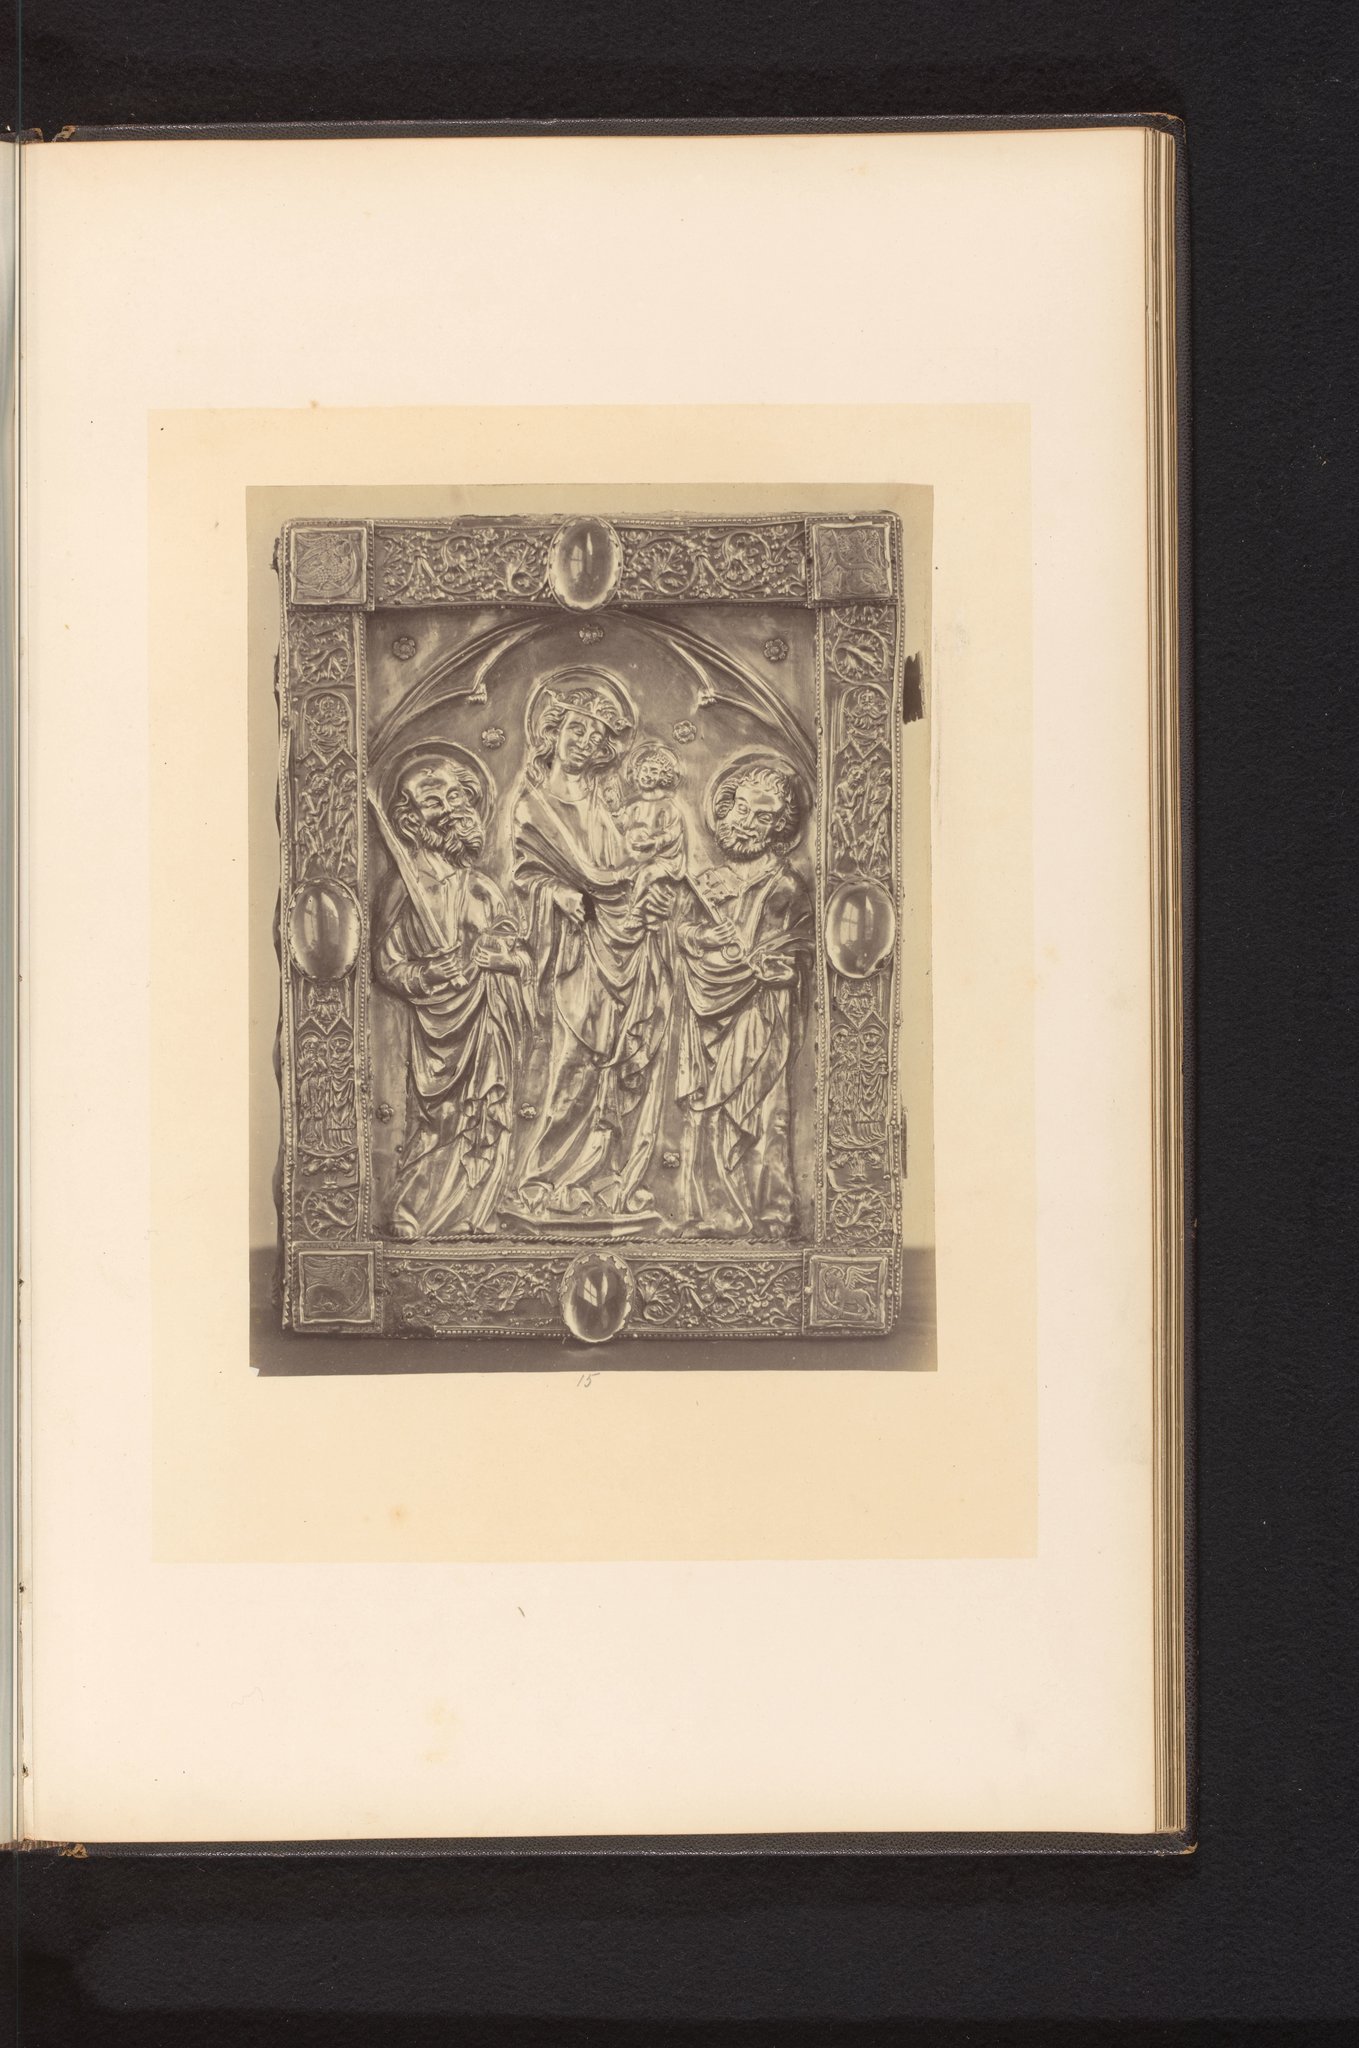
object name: photograph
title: Boekband met Maria en kind en Pieter en Paulus uit de Onze-Lieve-Vrouwebasiliek in Tongeren, opgesteld op een tentoonstelling over religieuze objecten uit de middeleeuwen en renaissance in 1864 in Mechelen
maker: joseph maes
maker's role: fotograaf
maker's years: 1838-1908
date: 1864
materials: photographic support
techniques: albumen print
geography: mechelen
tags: mary standing (or half-length), the christ-child sitting on her arm (christ-child to mary's left), book-cover, binding, mechelen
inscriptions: number: ‘15’